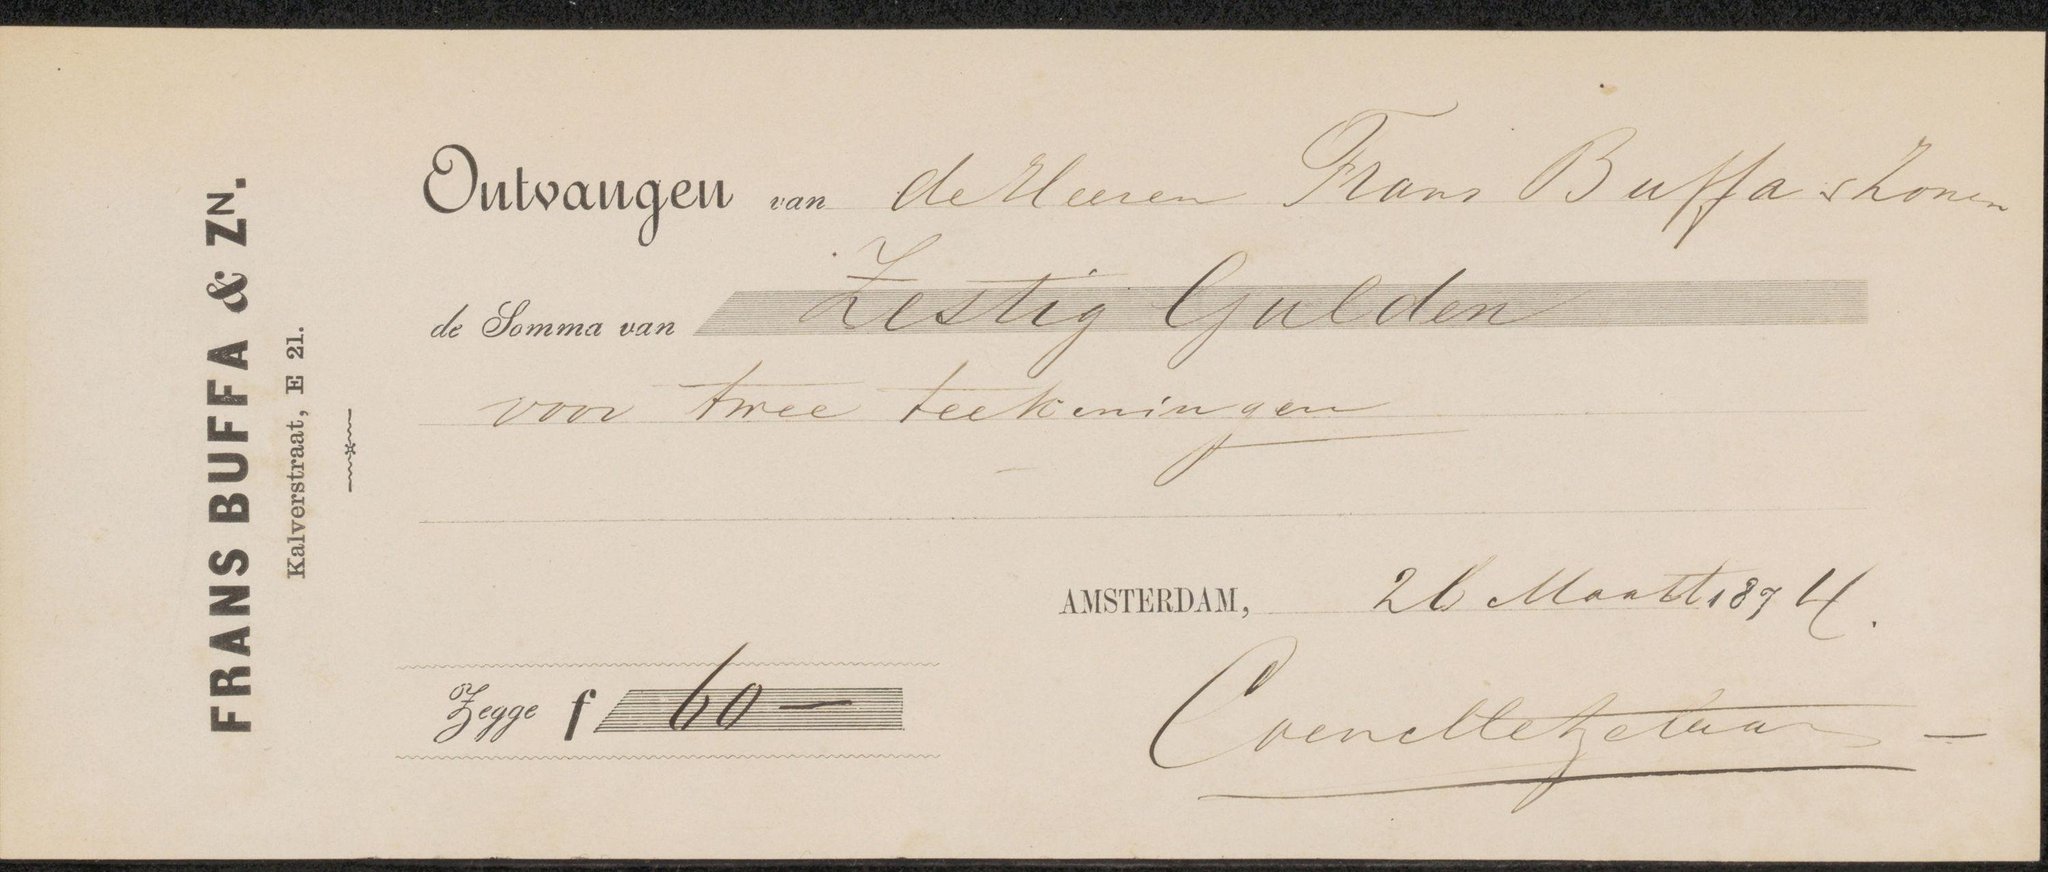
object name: ontvangstbewijs, kwitantie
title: Kwitantie voor Coen Metzelaar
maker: coen metzelaar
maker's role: draughtsman, painter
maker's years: 1845-1881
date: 1874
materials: ink, paper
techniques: pen, printing, writing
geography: amsterdam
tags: drawing, money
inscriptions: collector's mark: Lugt 2233